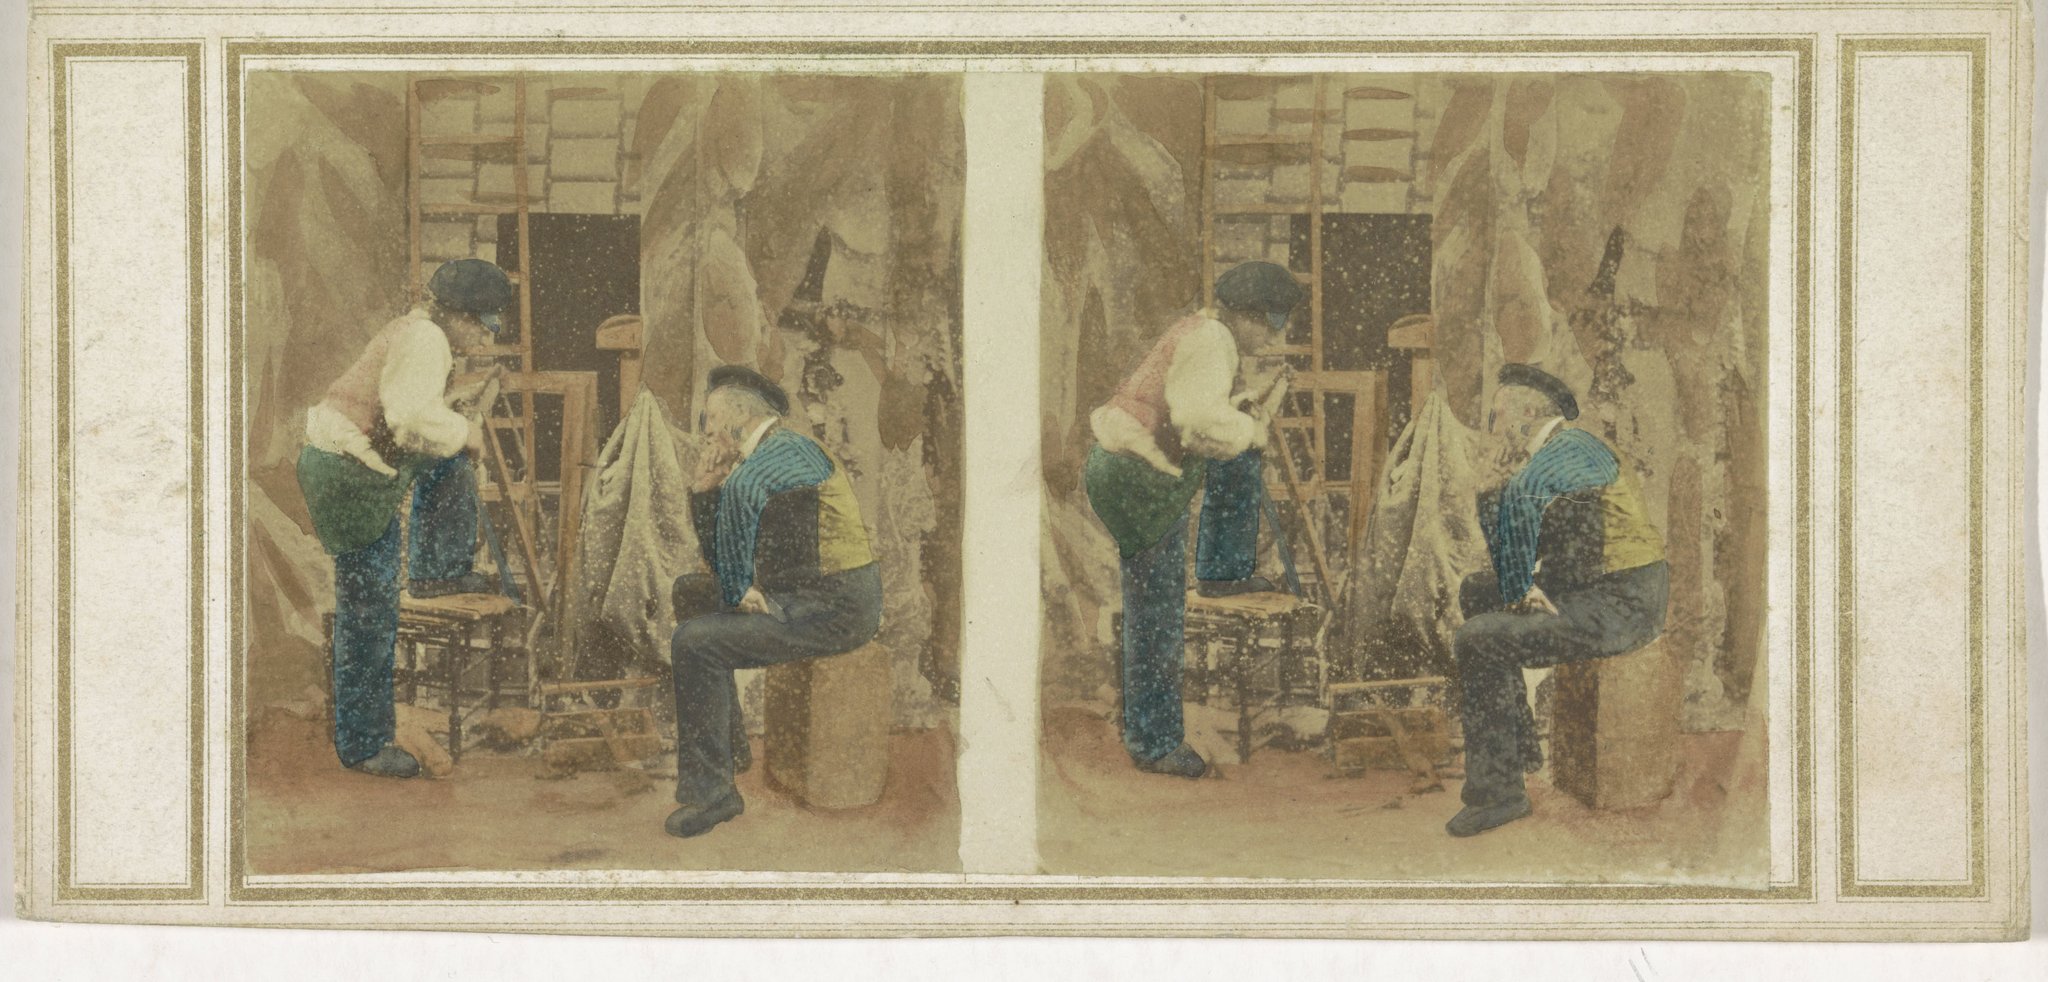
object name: stereograph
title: Twee mannen, naar beneden kijkend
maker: pierre-ambroise richebourg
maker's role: fotograaf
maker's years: 1810-1875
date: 1850-1870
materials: photographic support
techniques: albumen print, hand coloring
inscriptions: check stamp: ‘monogram LM (?)’, number: ‘539’